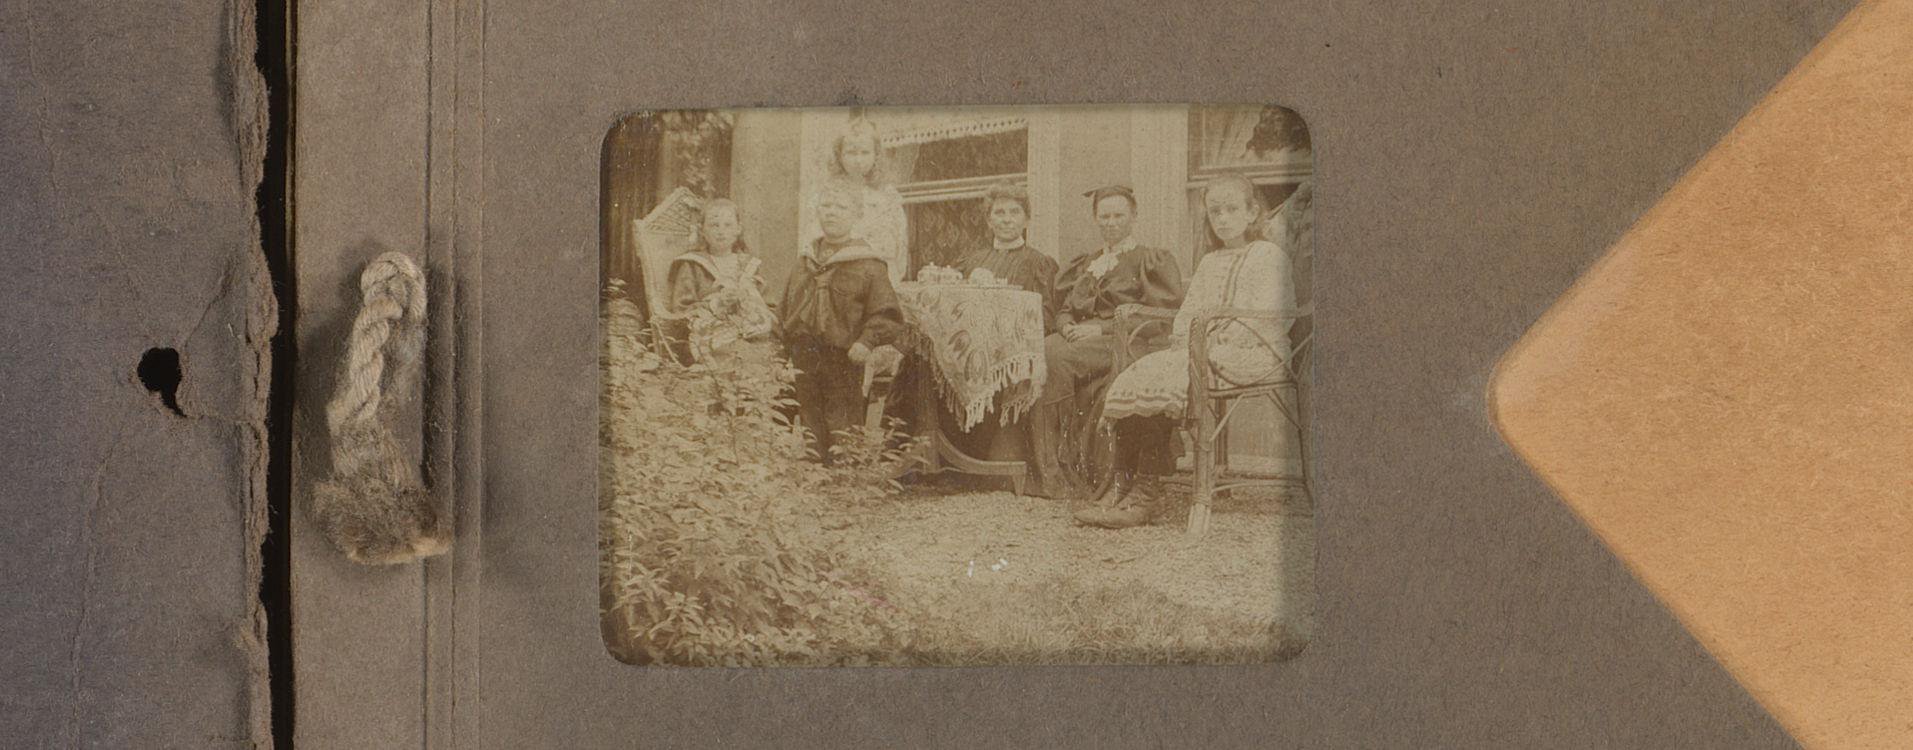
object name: album leaf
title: Gezin in een tuin, mogelijk de familie Merkus met links een meisje, aangeduid als Wiesje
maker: Anonymous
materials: paper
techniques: gelatin silver print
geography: gelderland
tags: wiesje merkus, family life, gelderland